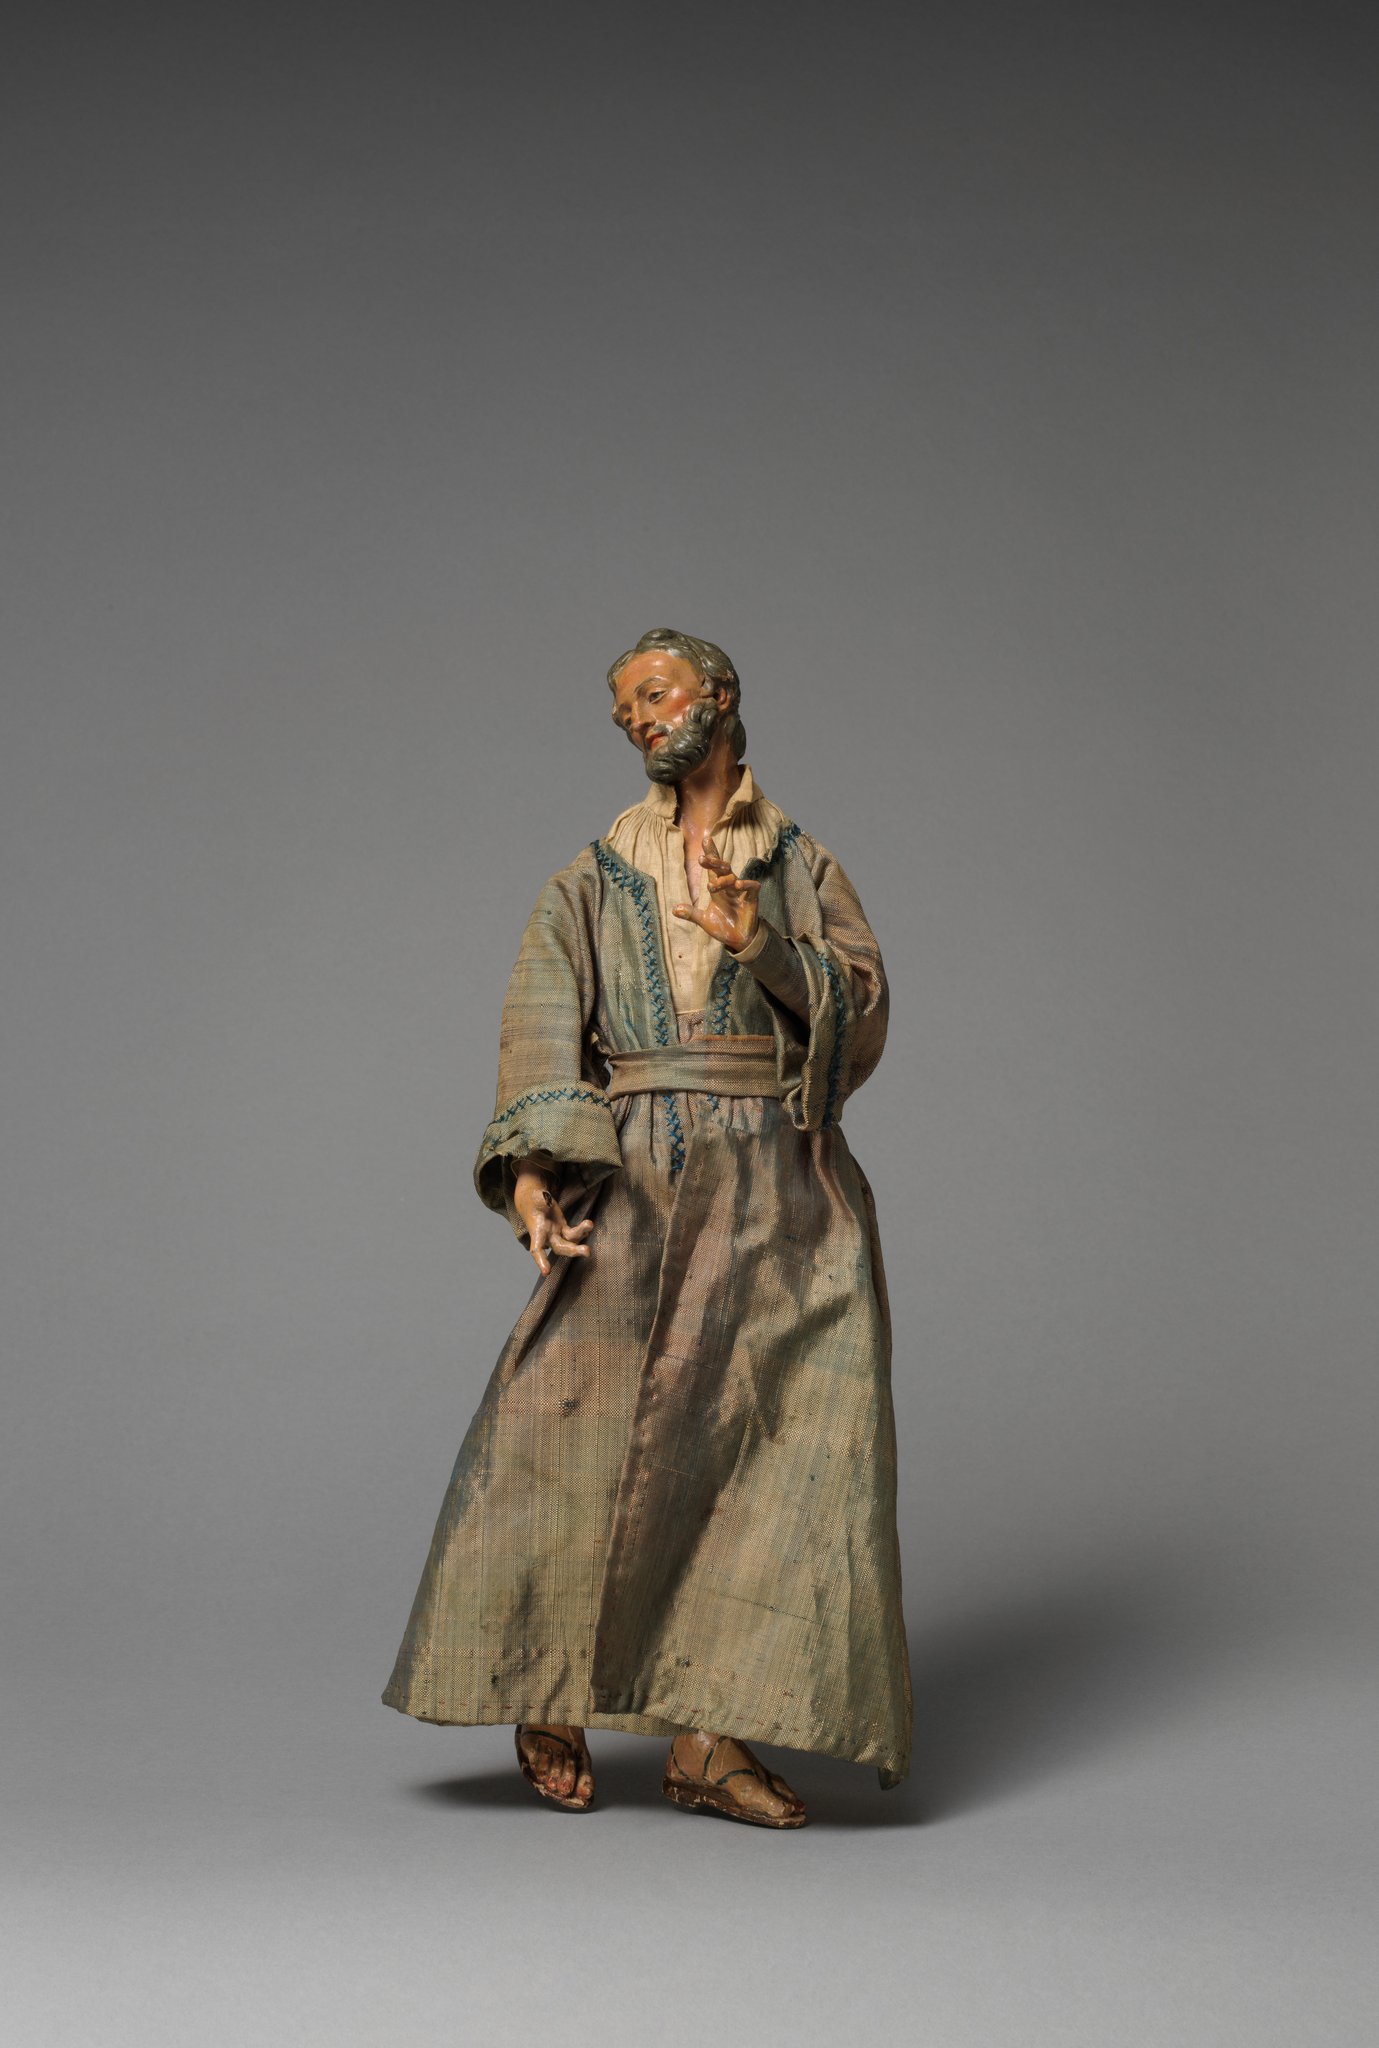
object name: crèche figure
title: Small “Joseph” with hand raised in purple/grey long robes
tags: men,saint joseph